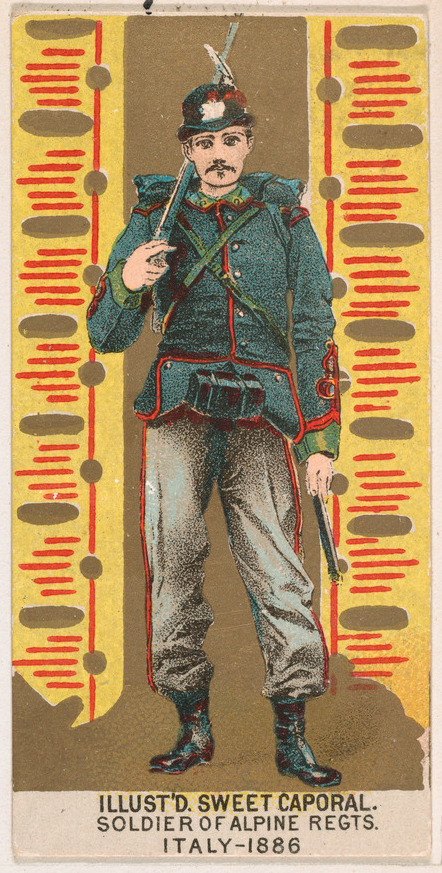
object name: print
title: Soldier of Alpine Regiments, Italy, 1886, from the Military Series (N224) issued by Kinney Tobacco Company to promote Sweet Caporal Cigarettes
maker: kinney brothers tobacco company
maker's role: publisher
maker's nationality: american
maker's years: 1869-2011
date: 1888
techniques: color lithograph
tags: military,weapons,men